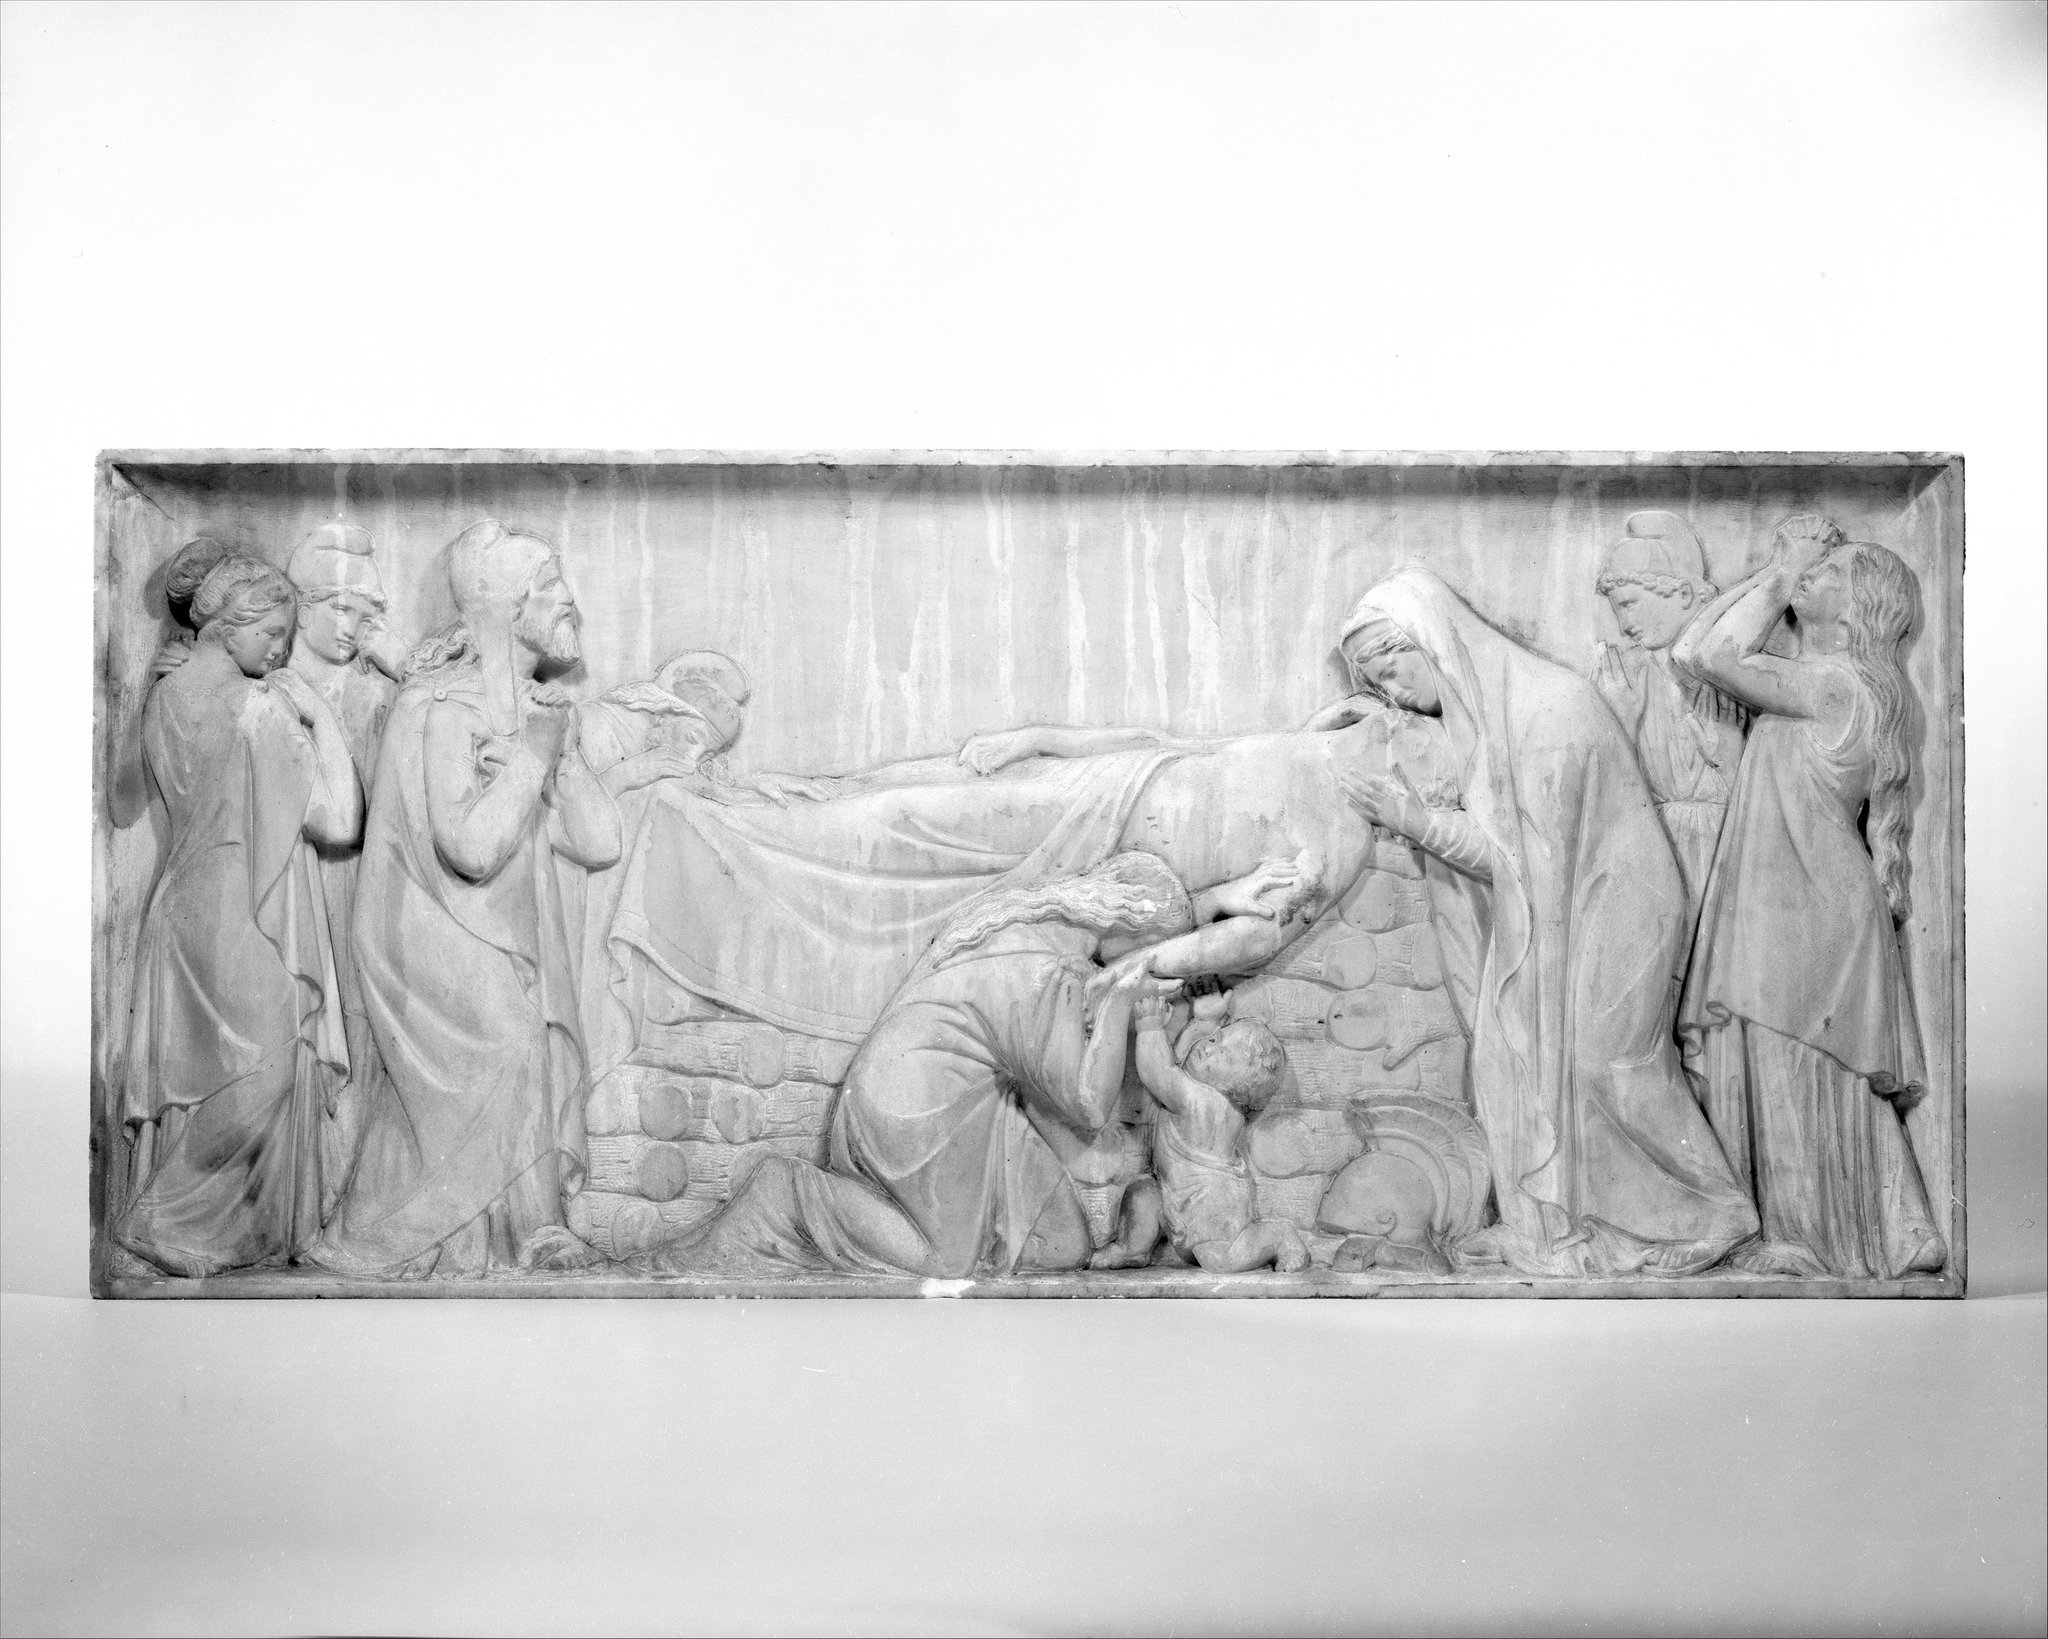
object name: relief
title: Hector lying on his funeral pyre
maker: giovanni maria benzoni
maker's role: artist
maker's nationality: italian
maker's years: 1809-1873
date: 1801-1900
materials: marble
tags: sadness,children,men,women,funerals,death